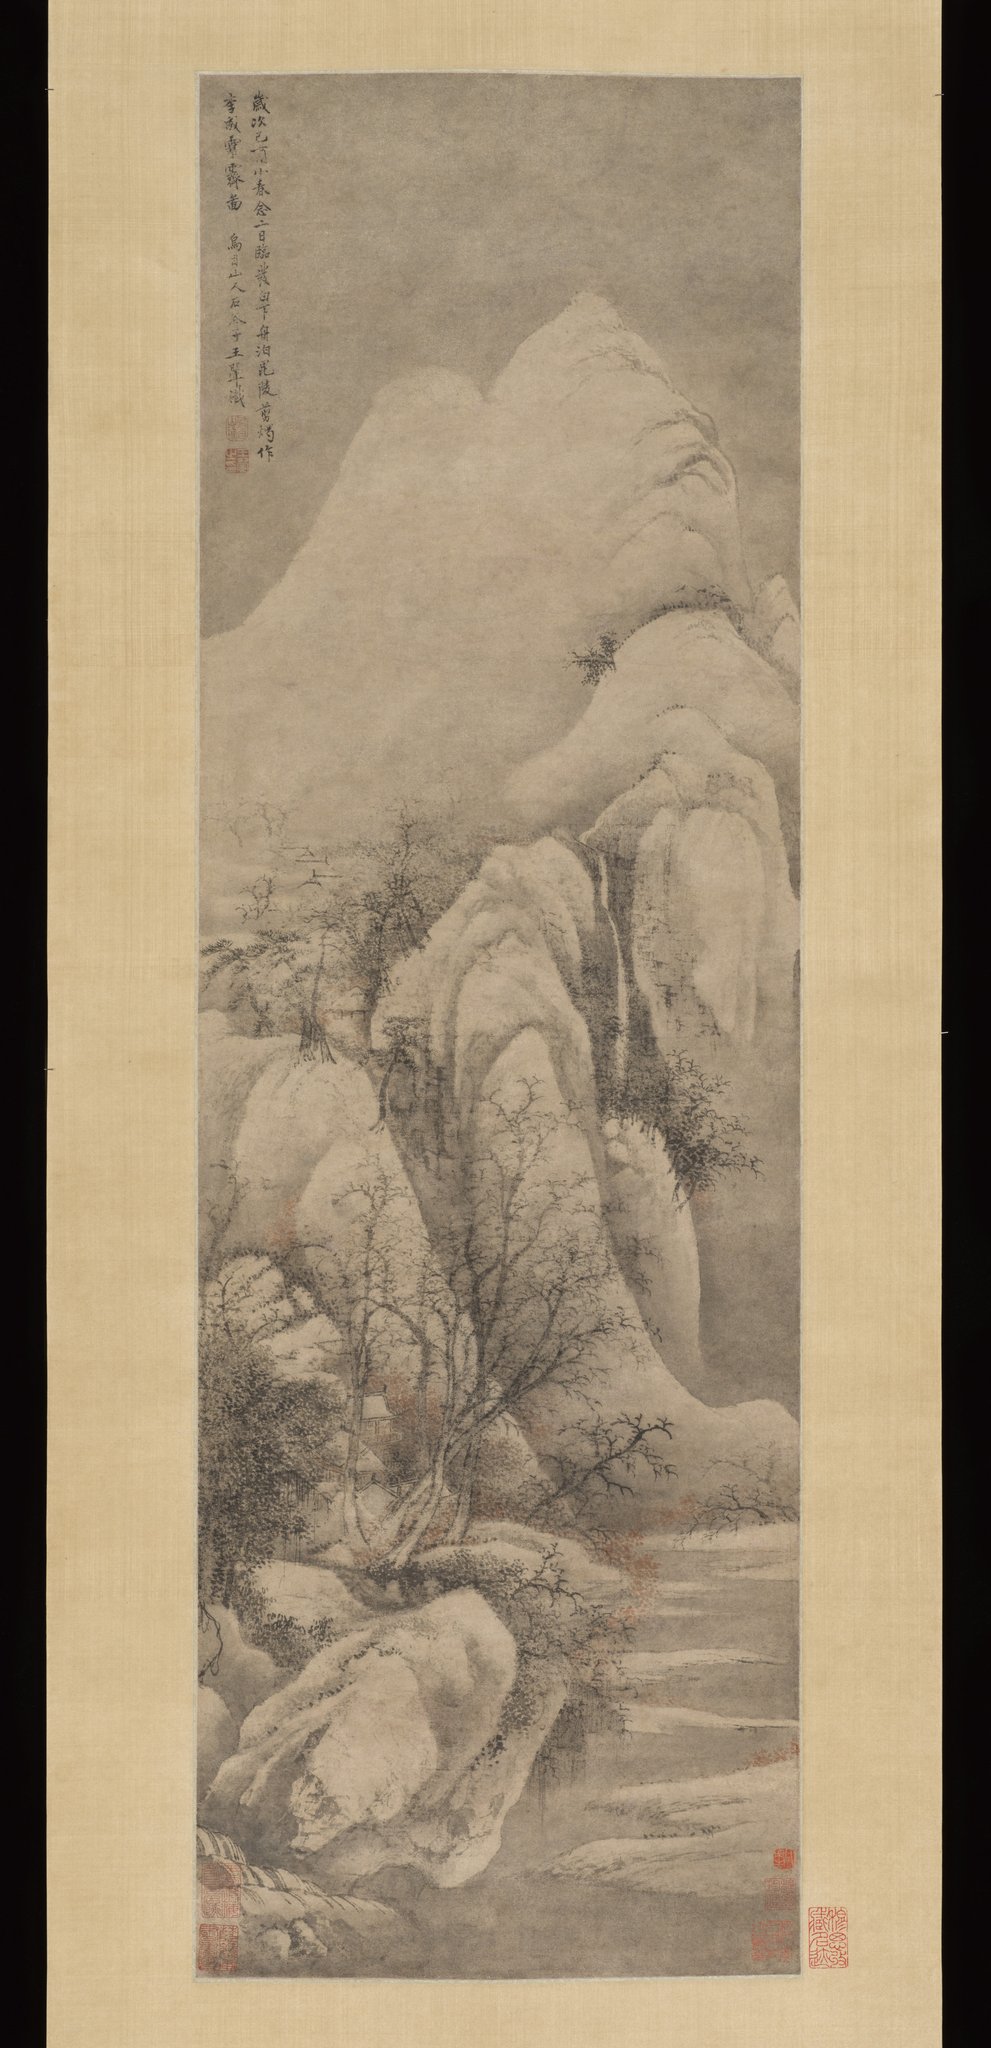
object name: hanging scroll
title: Snow Clearing: Landscape after Li Cheng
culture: chinese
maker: wang hui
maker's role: artist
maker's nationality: chinese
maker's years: 1632-1717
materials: ink, paper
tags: mountains,landscapes,snow